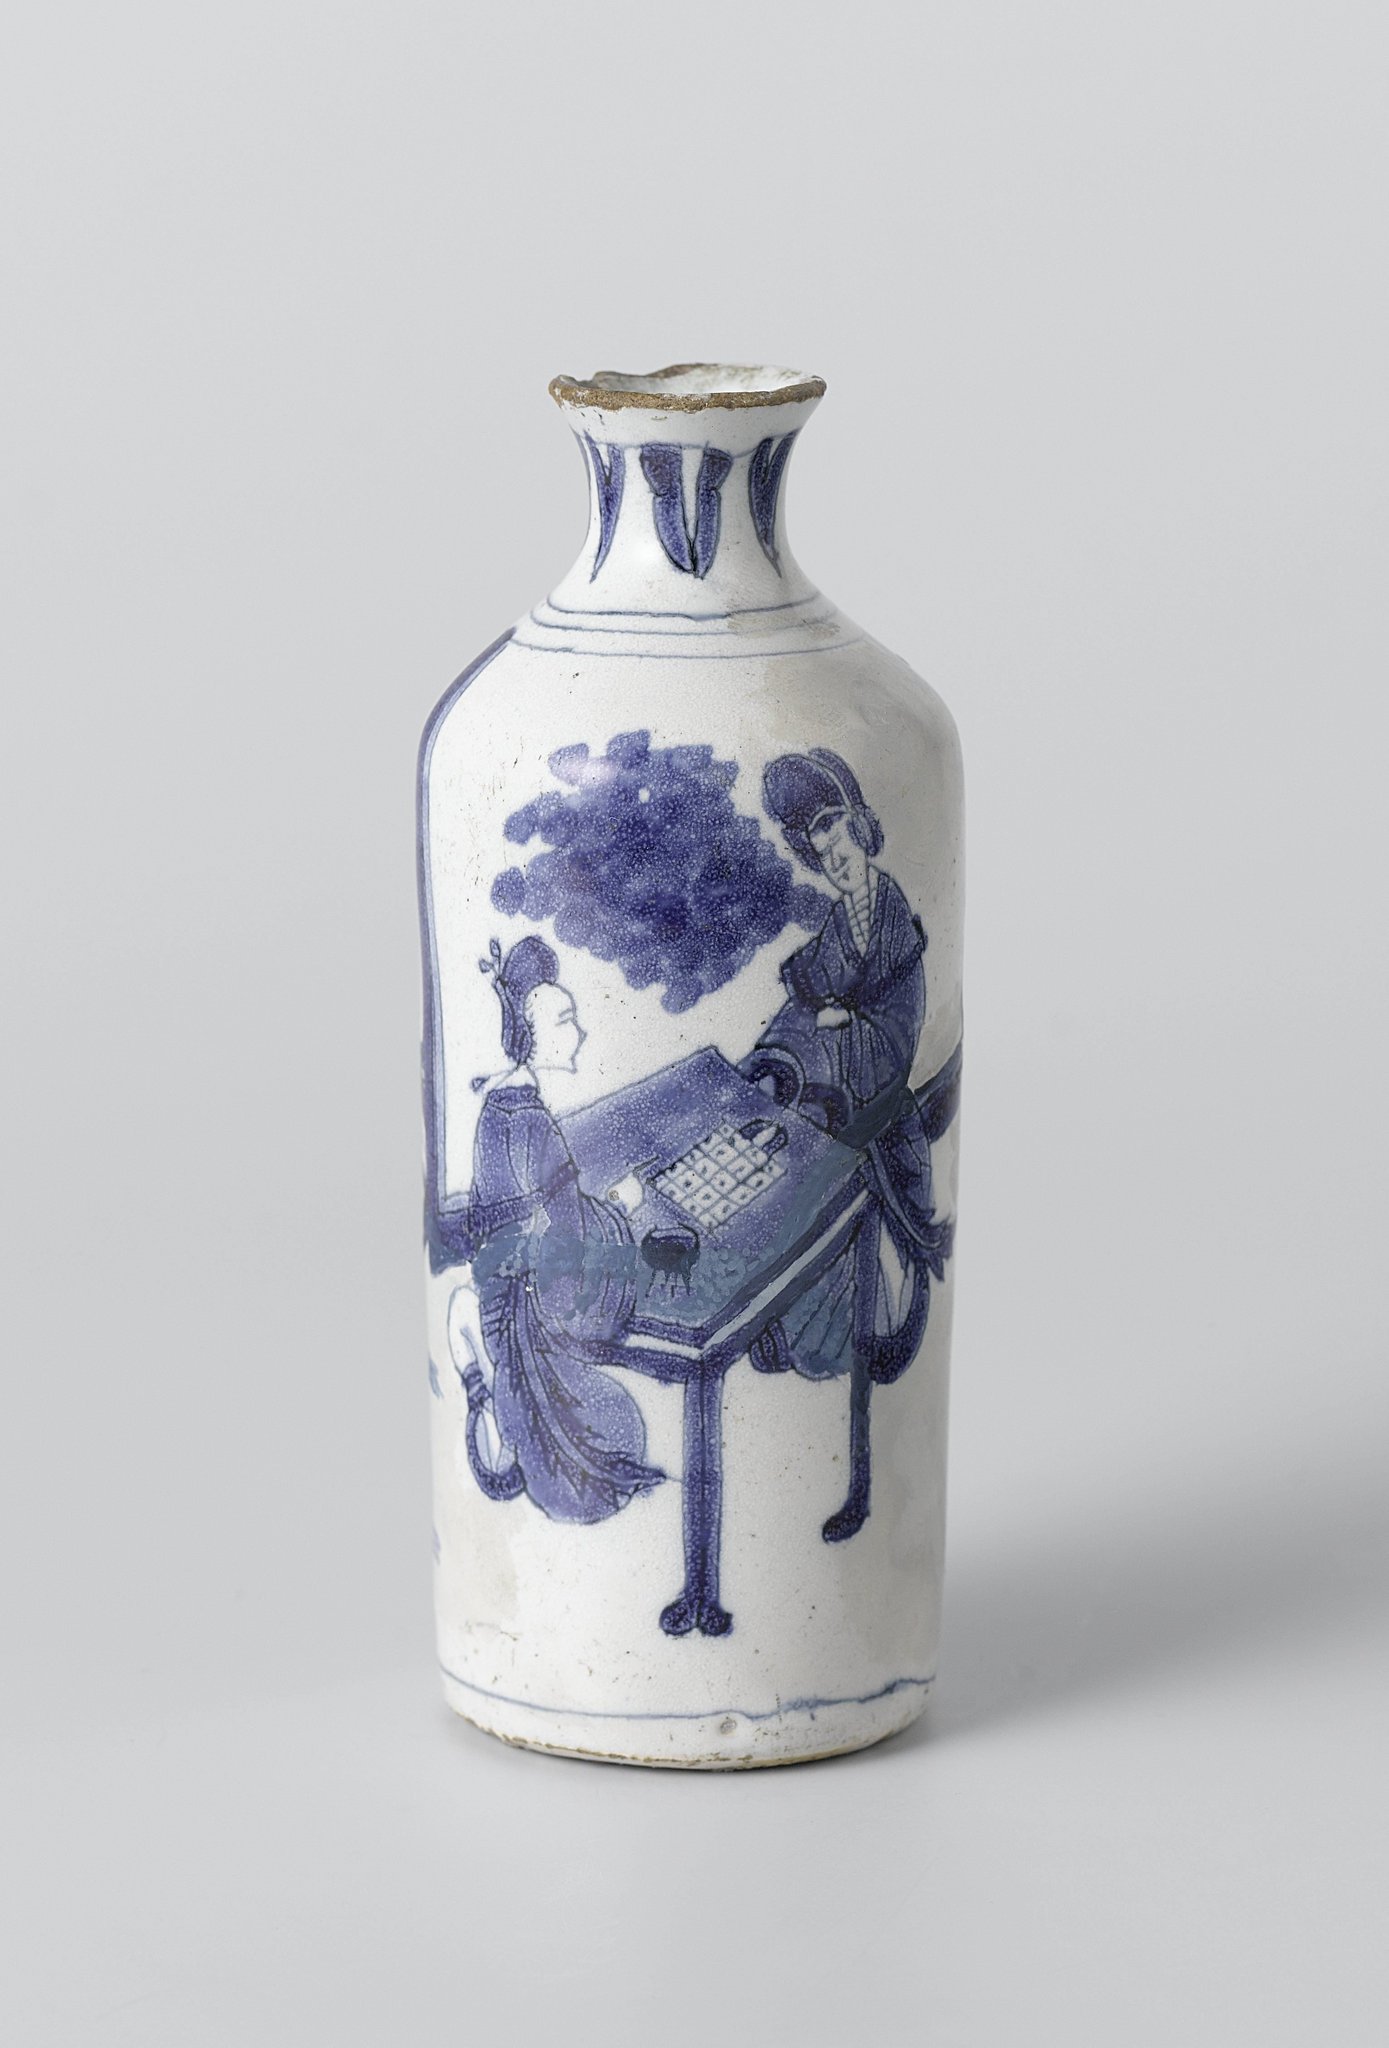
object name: rolwagen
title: Rolwagen van blauw beschilderde faience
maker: Anonymous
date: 1690-1720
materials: faience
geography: delft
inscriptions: mark: ‘118 figuratief teken plus’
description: Rolwagen van faience. Blauw beschilderd met twee go-spelende Chinese vrouwen.